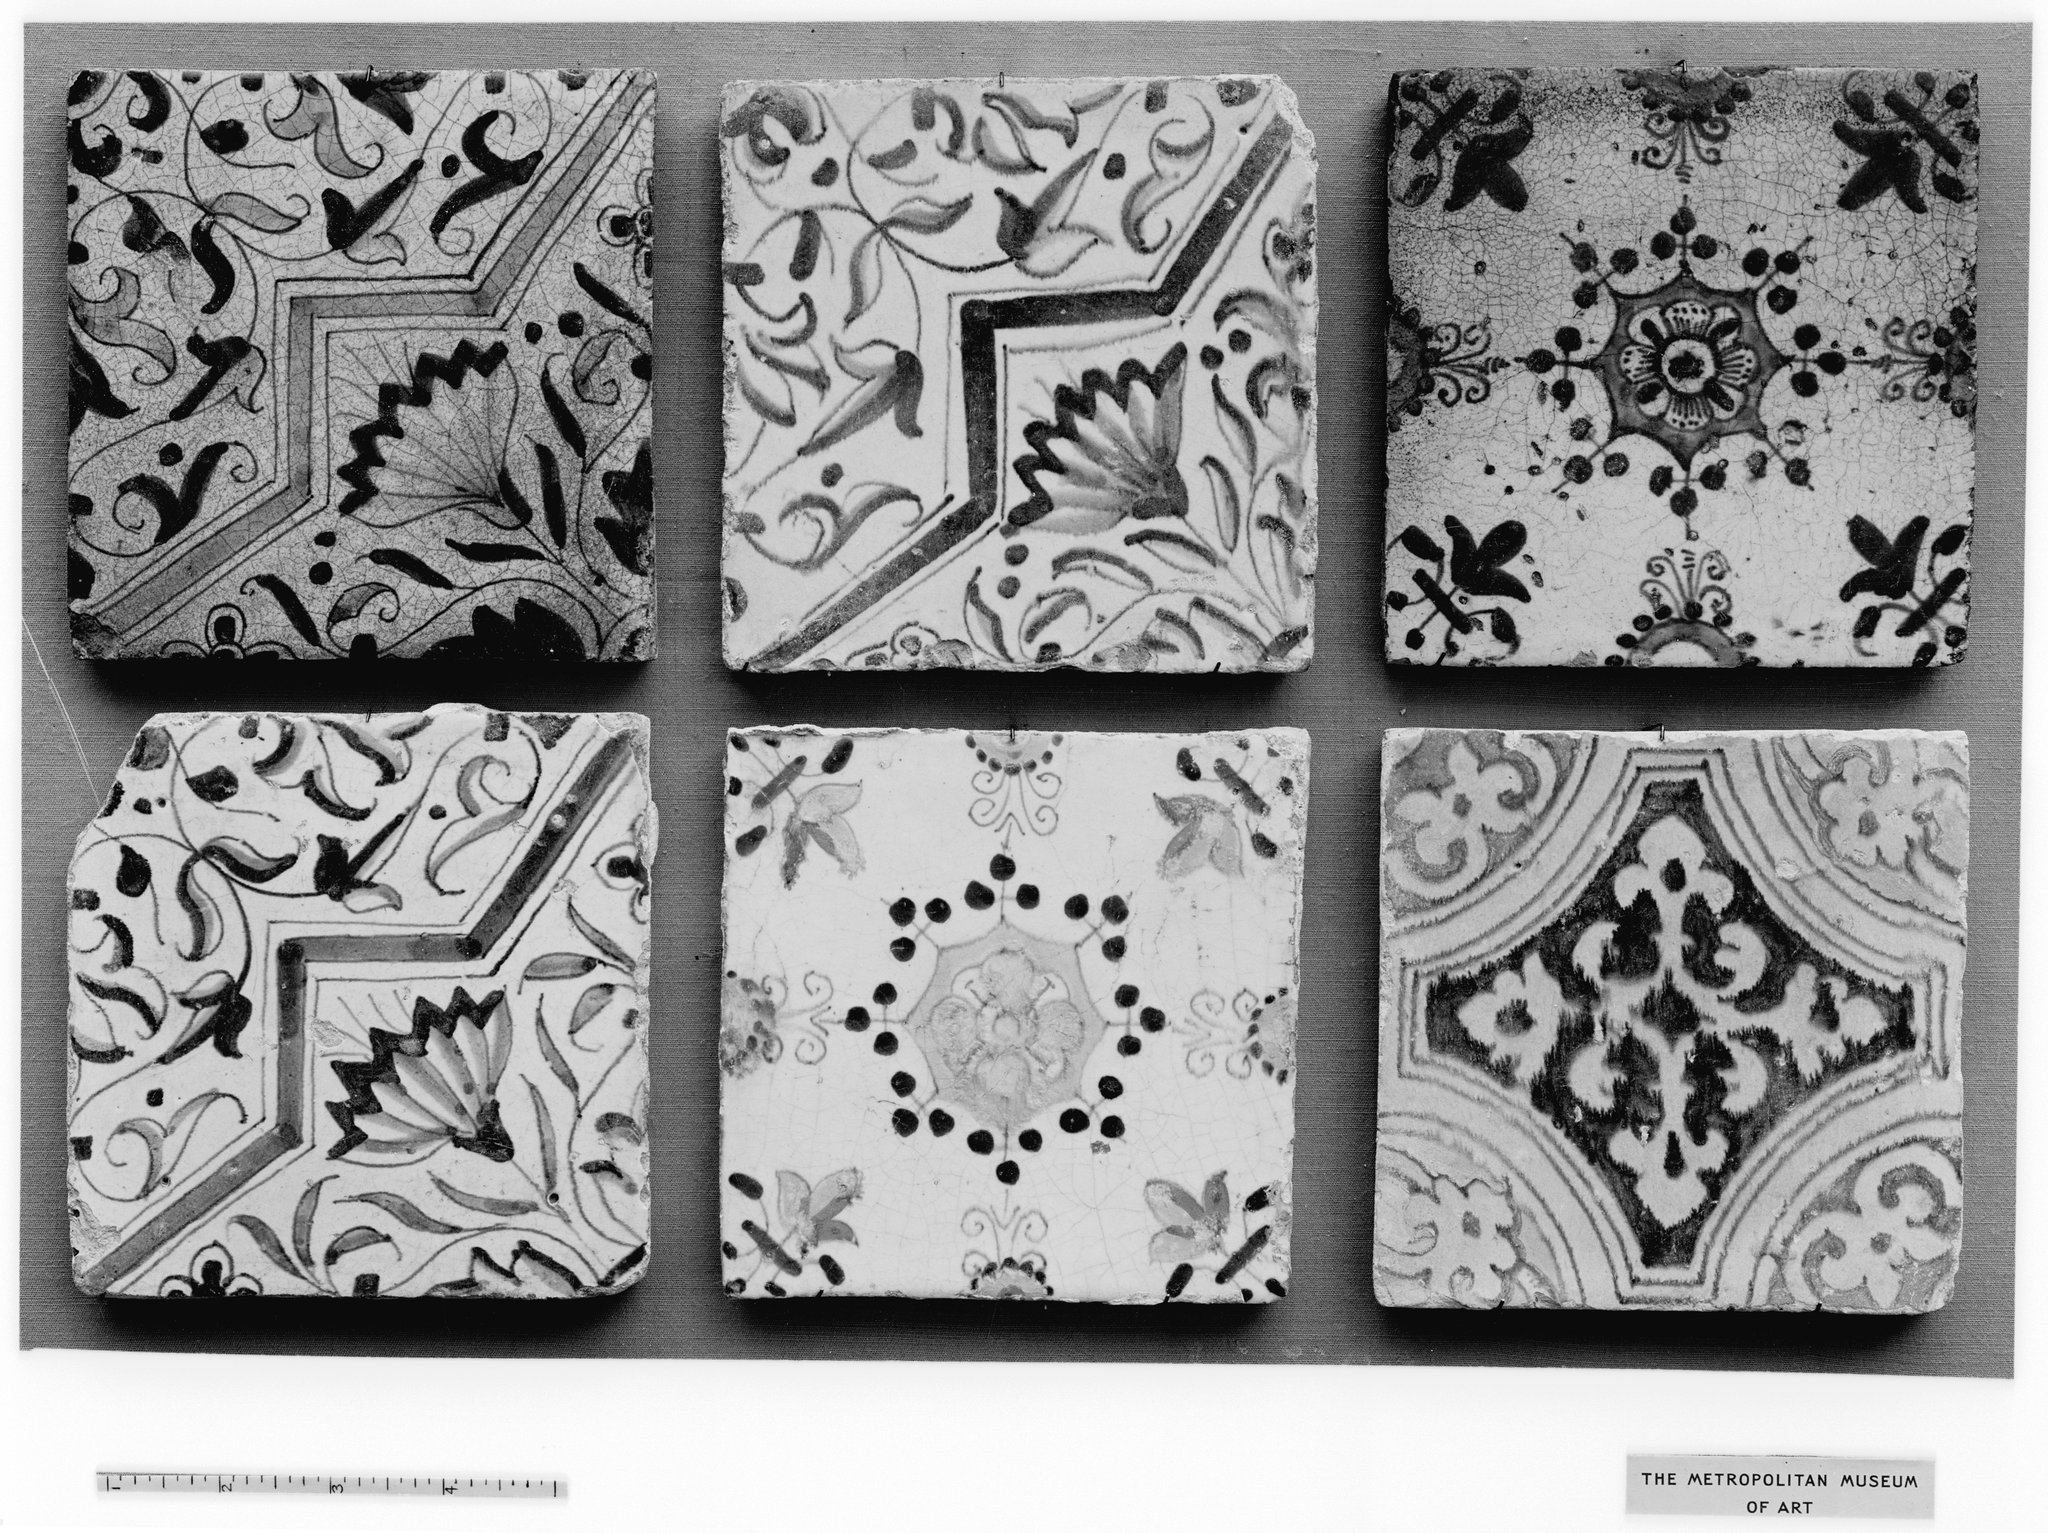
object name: tile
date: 1640-1660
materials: earthenware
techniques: glazing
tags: flowers